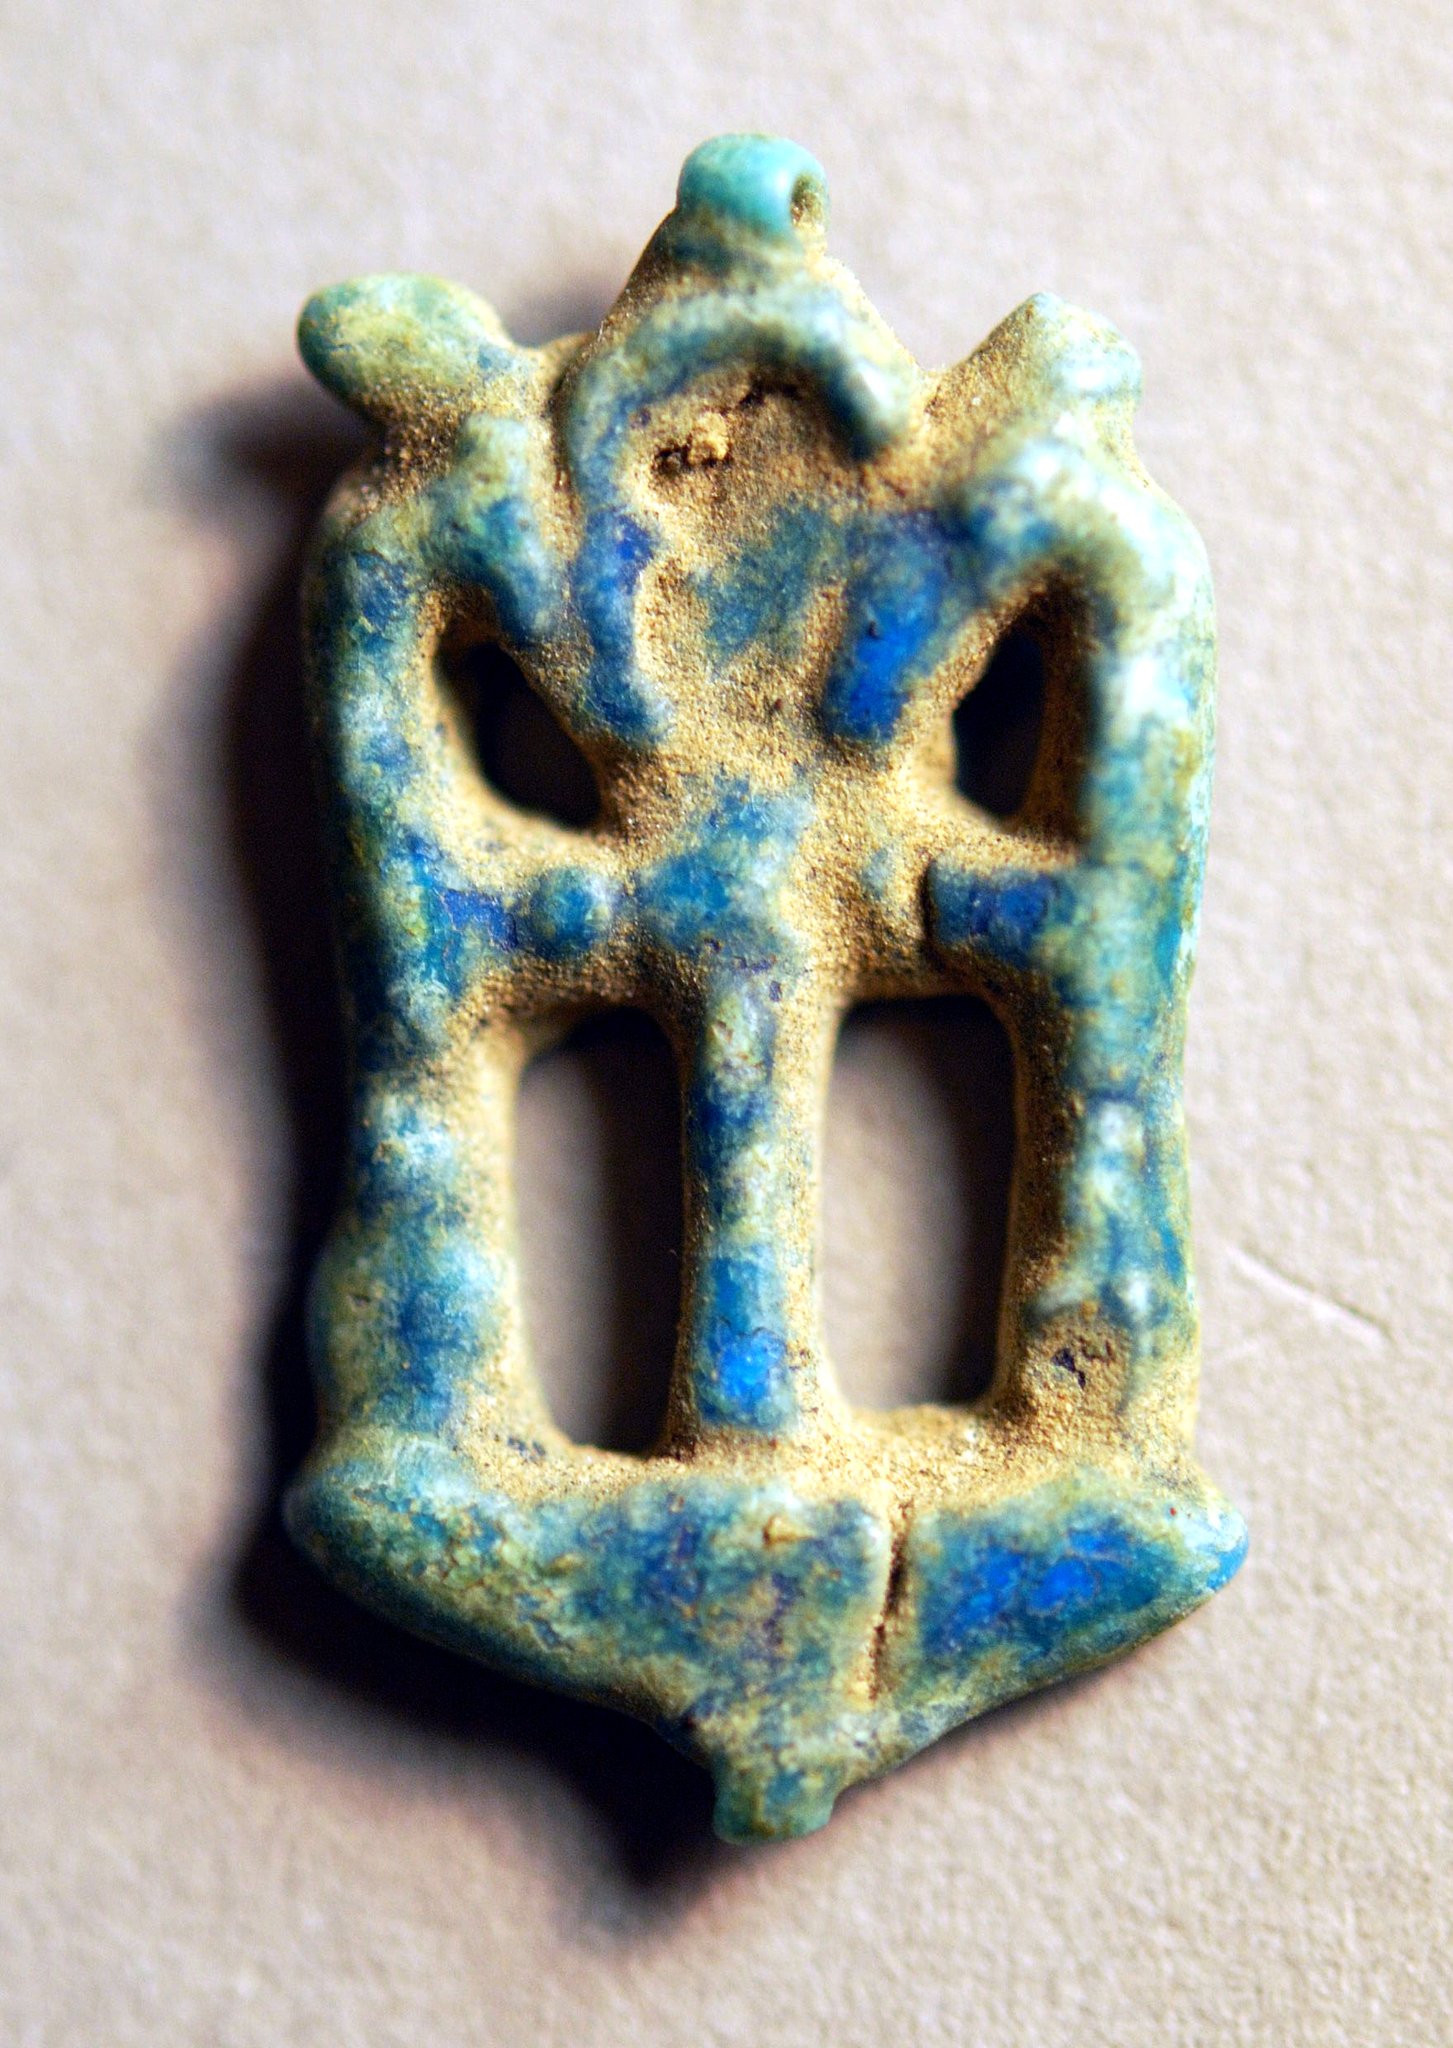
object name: amulet, ankh, wa scepter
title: Amulet with an Ankh and Two Was Scepters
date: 1390-1352 BCE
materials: faience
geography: egypt